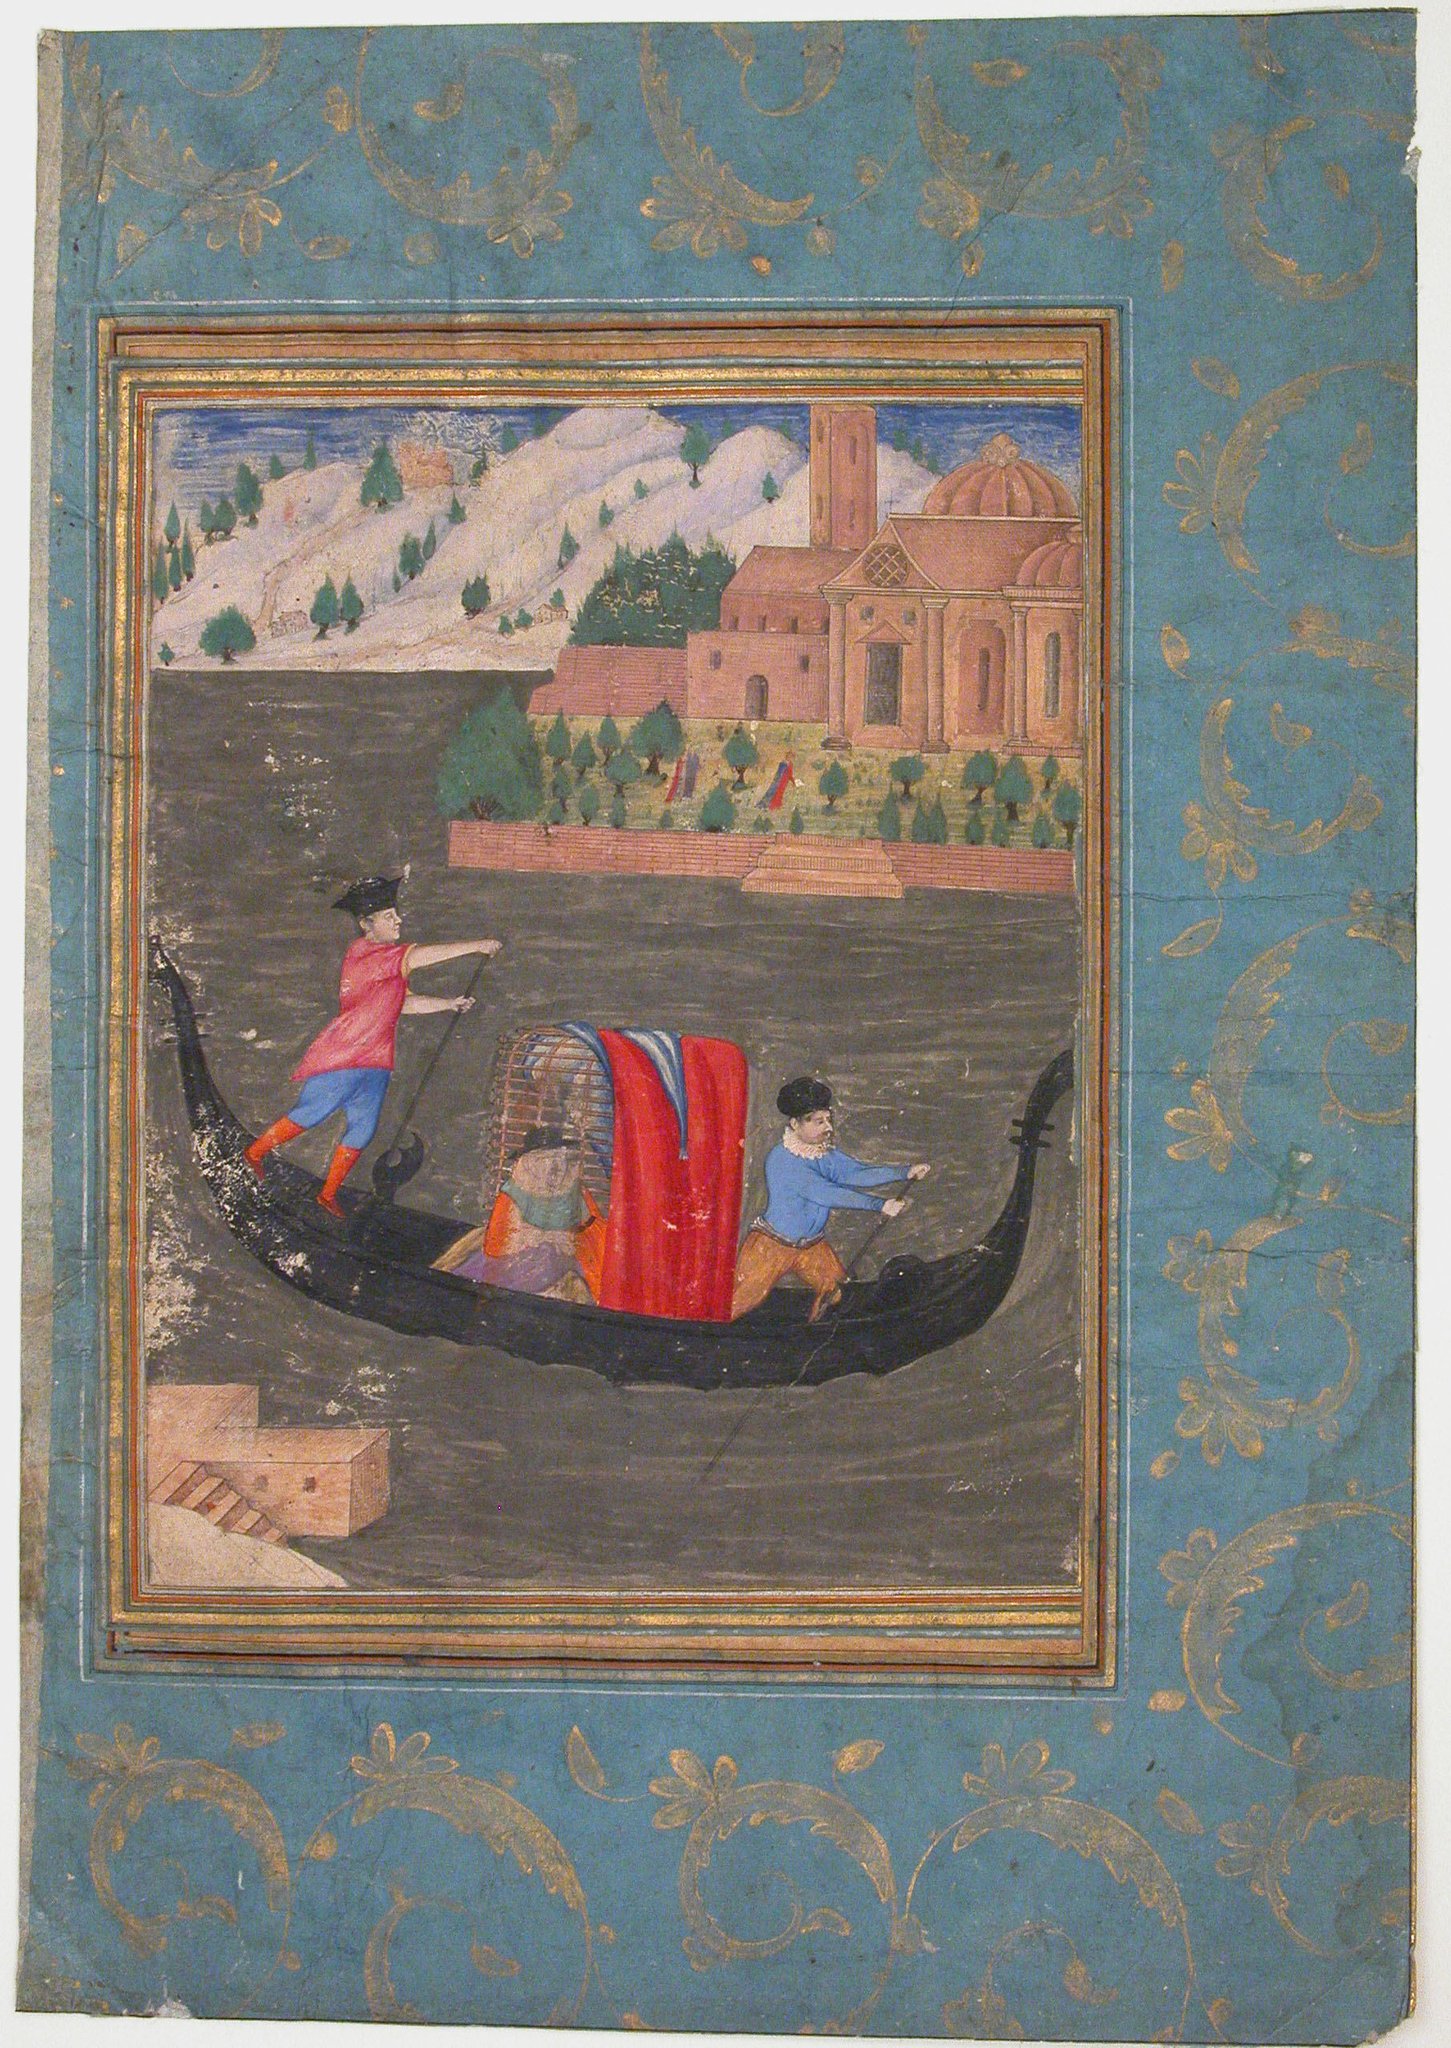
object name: illustrated album leaf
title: Aquatic Scene with Three Men in a Gondola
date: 1567-1633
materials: gold, ink, paper, watercolor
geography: turkey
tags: men,boats